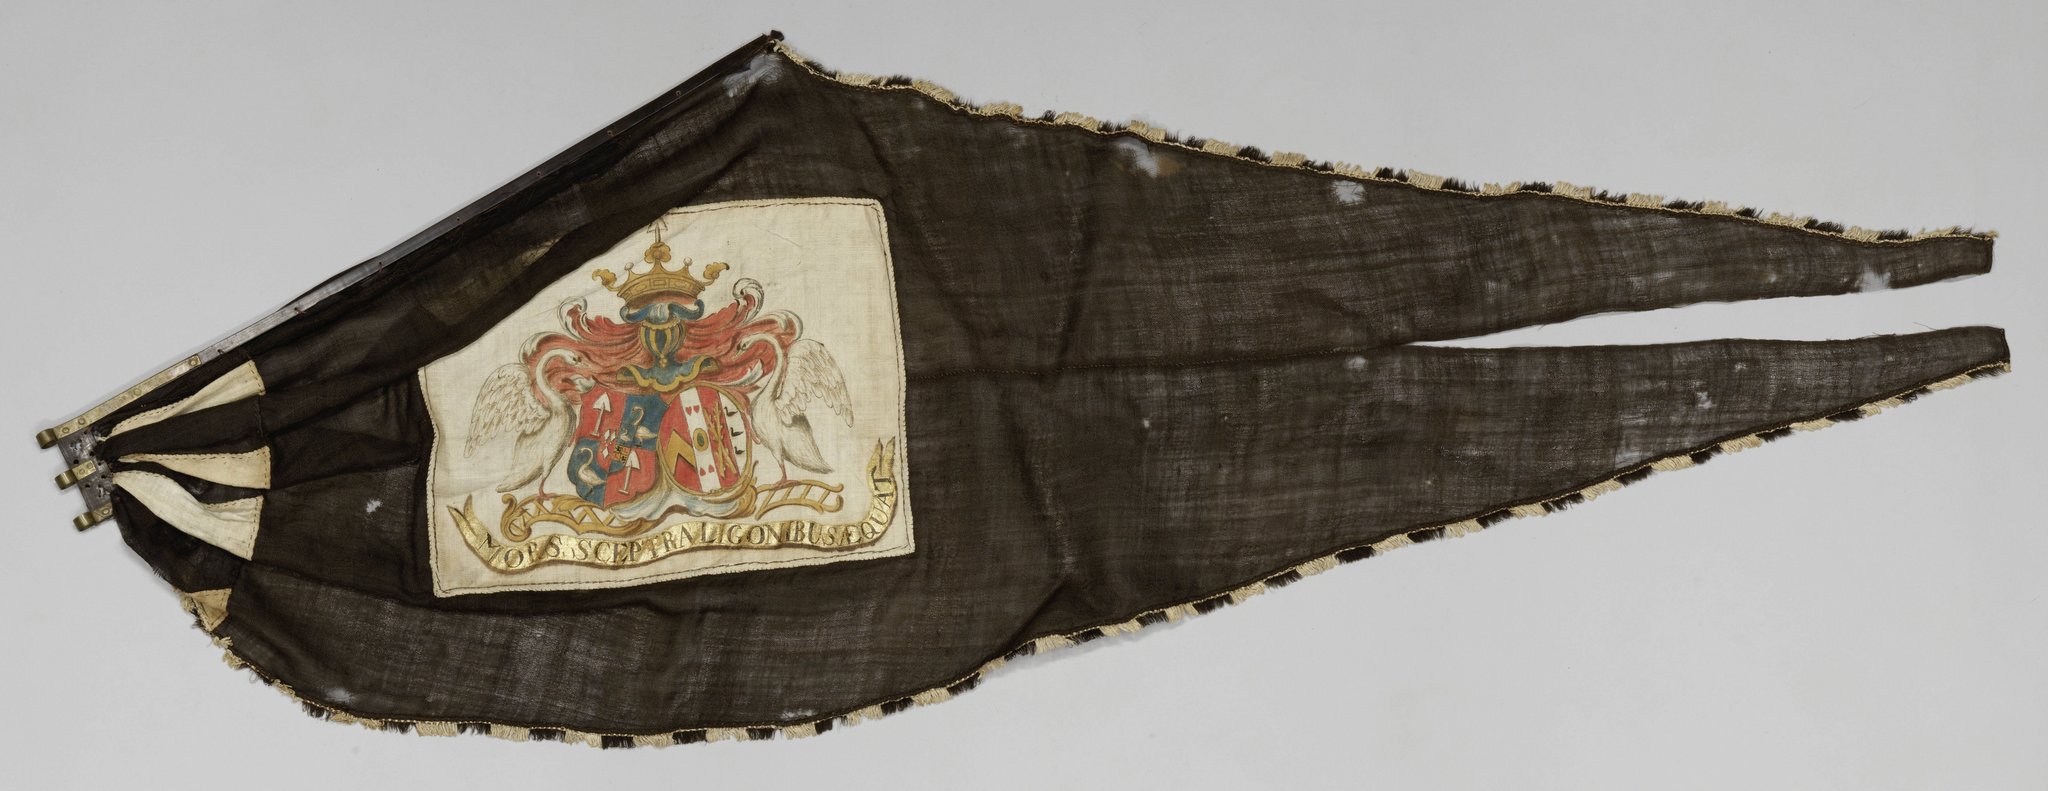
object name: rouwwimpel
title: Rouwwimpel aan benen strip met bronzen banden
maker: Anonymous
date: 1767-1798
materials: linen, paint, wool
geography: netherlands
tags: amsterdam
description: Zwarte wimpel. Aan broekzijde bevestigd aan benen strip. De broek is zelf opgebouwd uit acht afgeknotte driehoeken, die gerimpeld aan het been zijn bevestigd, zodat een bolle vorm ontstaat. In het zwart is een witte rechthoek genaaid, met de wapens van Gerrit de Graeff en Christina van Herzeele, onder een helm in blauw met oker tegen rood lofwerk. Hierboven een kroon met vijf punten: drie met fleurons, twee met parels, afwisselend, en boven de middelste een rechtopstaande troffel met okerkleurige steel en blauwe schep. Terweerszijden van de wapens een zwaan. Dit alles staat op een asymmetrische voet met lofwerk. Hieronder een banderol in goud, waarop: MORS, SCEPTRA, LIGONIBUS, AEQUAT. Achterkant identiek; alleen zijn de wapens omgewisseld. Langs de randen zwart-wit geblokte franje. Vlucht gespleten.